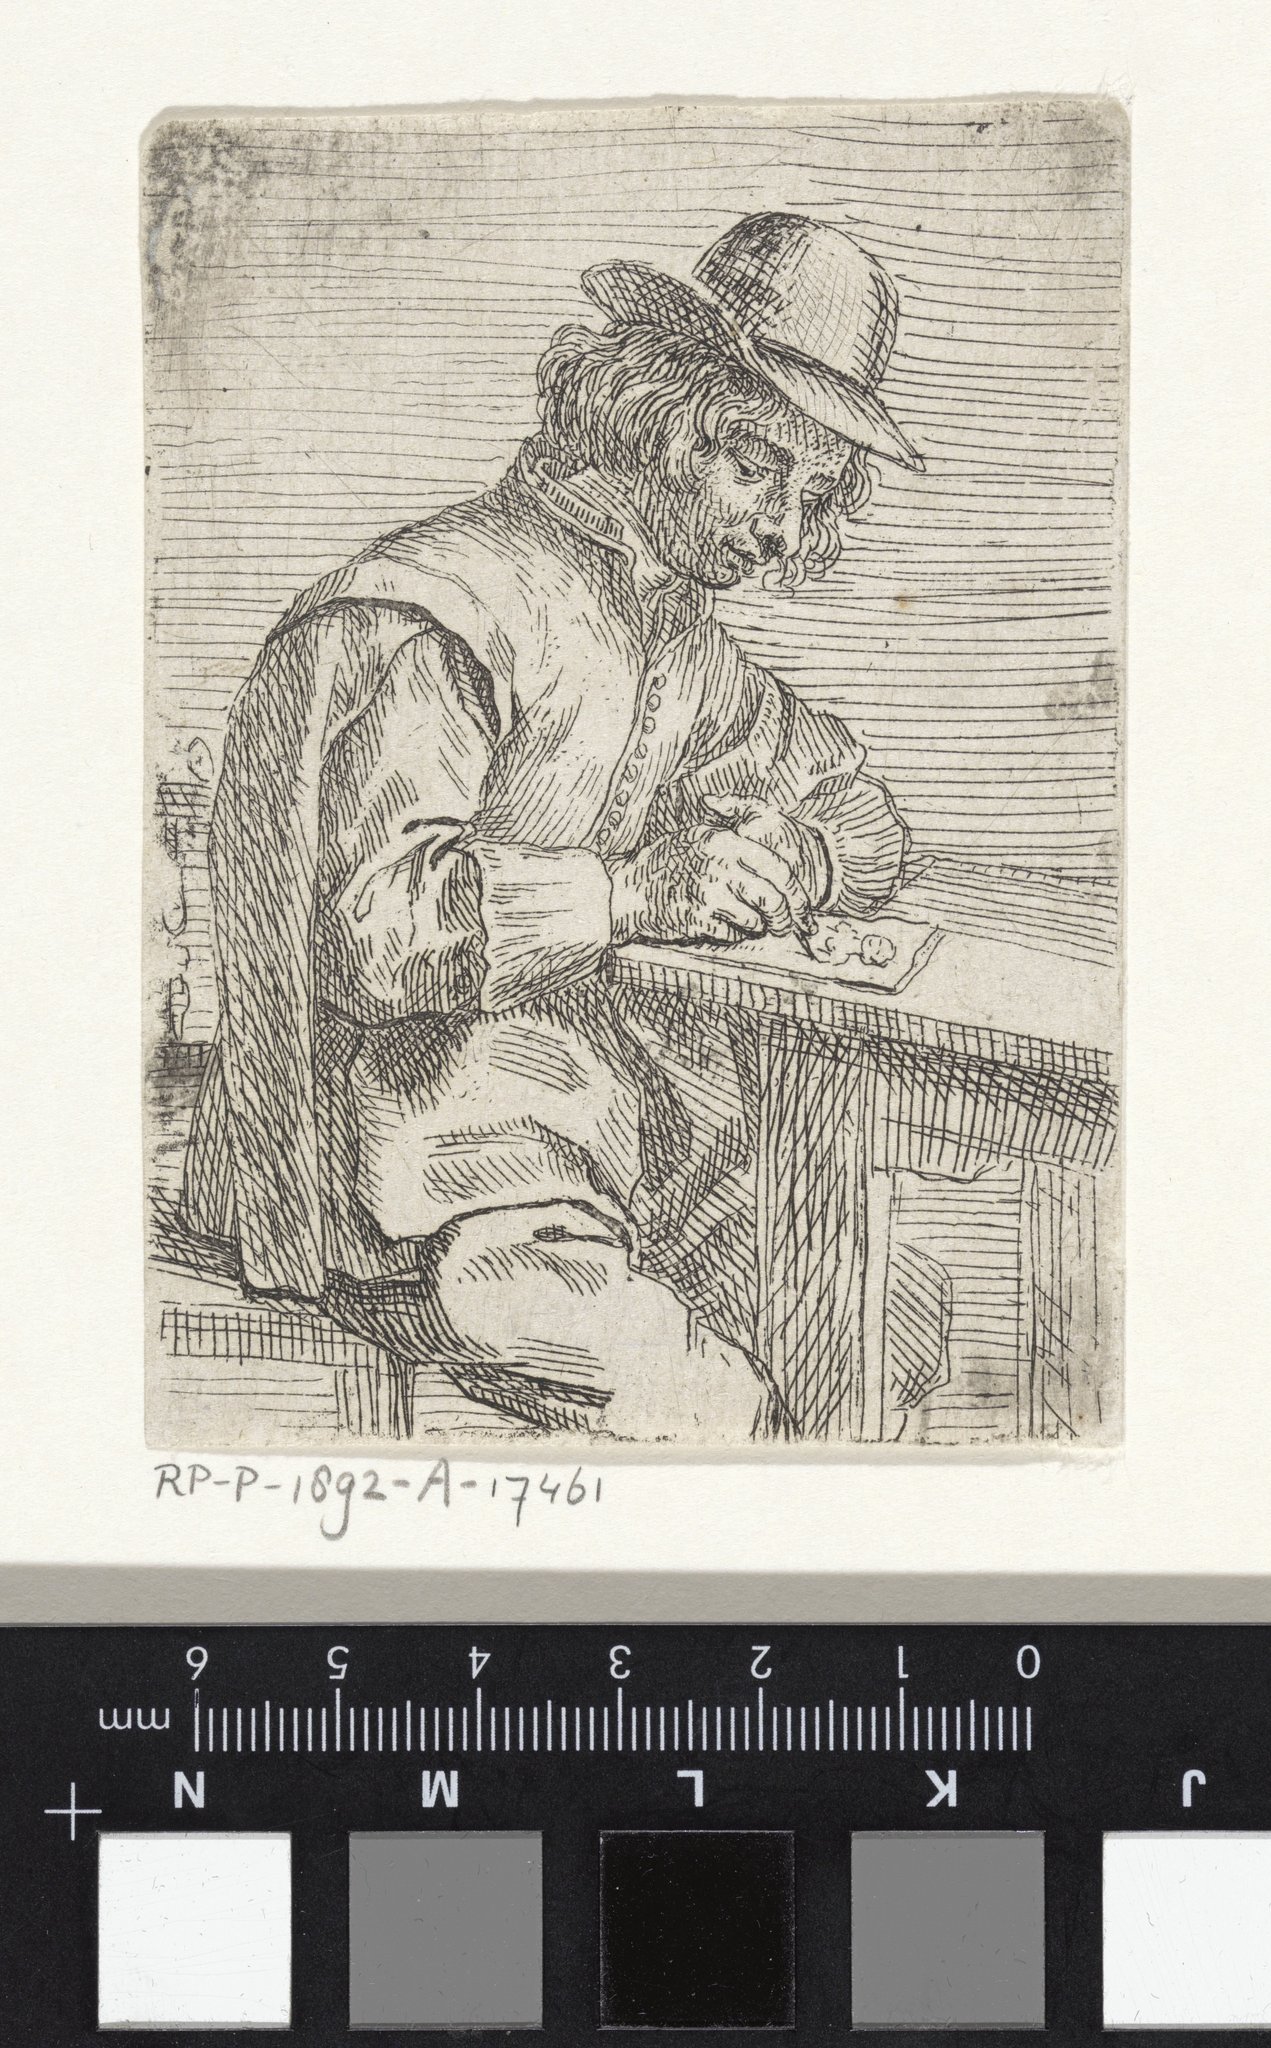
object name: print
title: Tekenende man met hoed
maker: peeter snijers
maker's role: painter, print maker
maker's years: 1681-1752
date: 1694-1752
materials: paper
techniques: etching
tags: artist (in general) making preliminary designs, sketching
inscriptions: collector's mark: Lugt 514, collector's mark: Lugt 2228